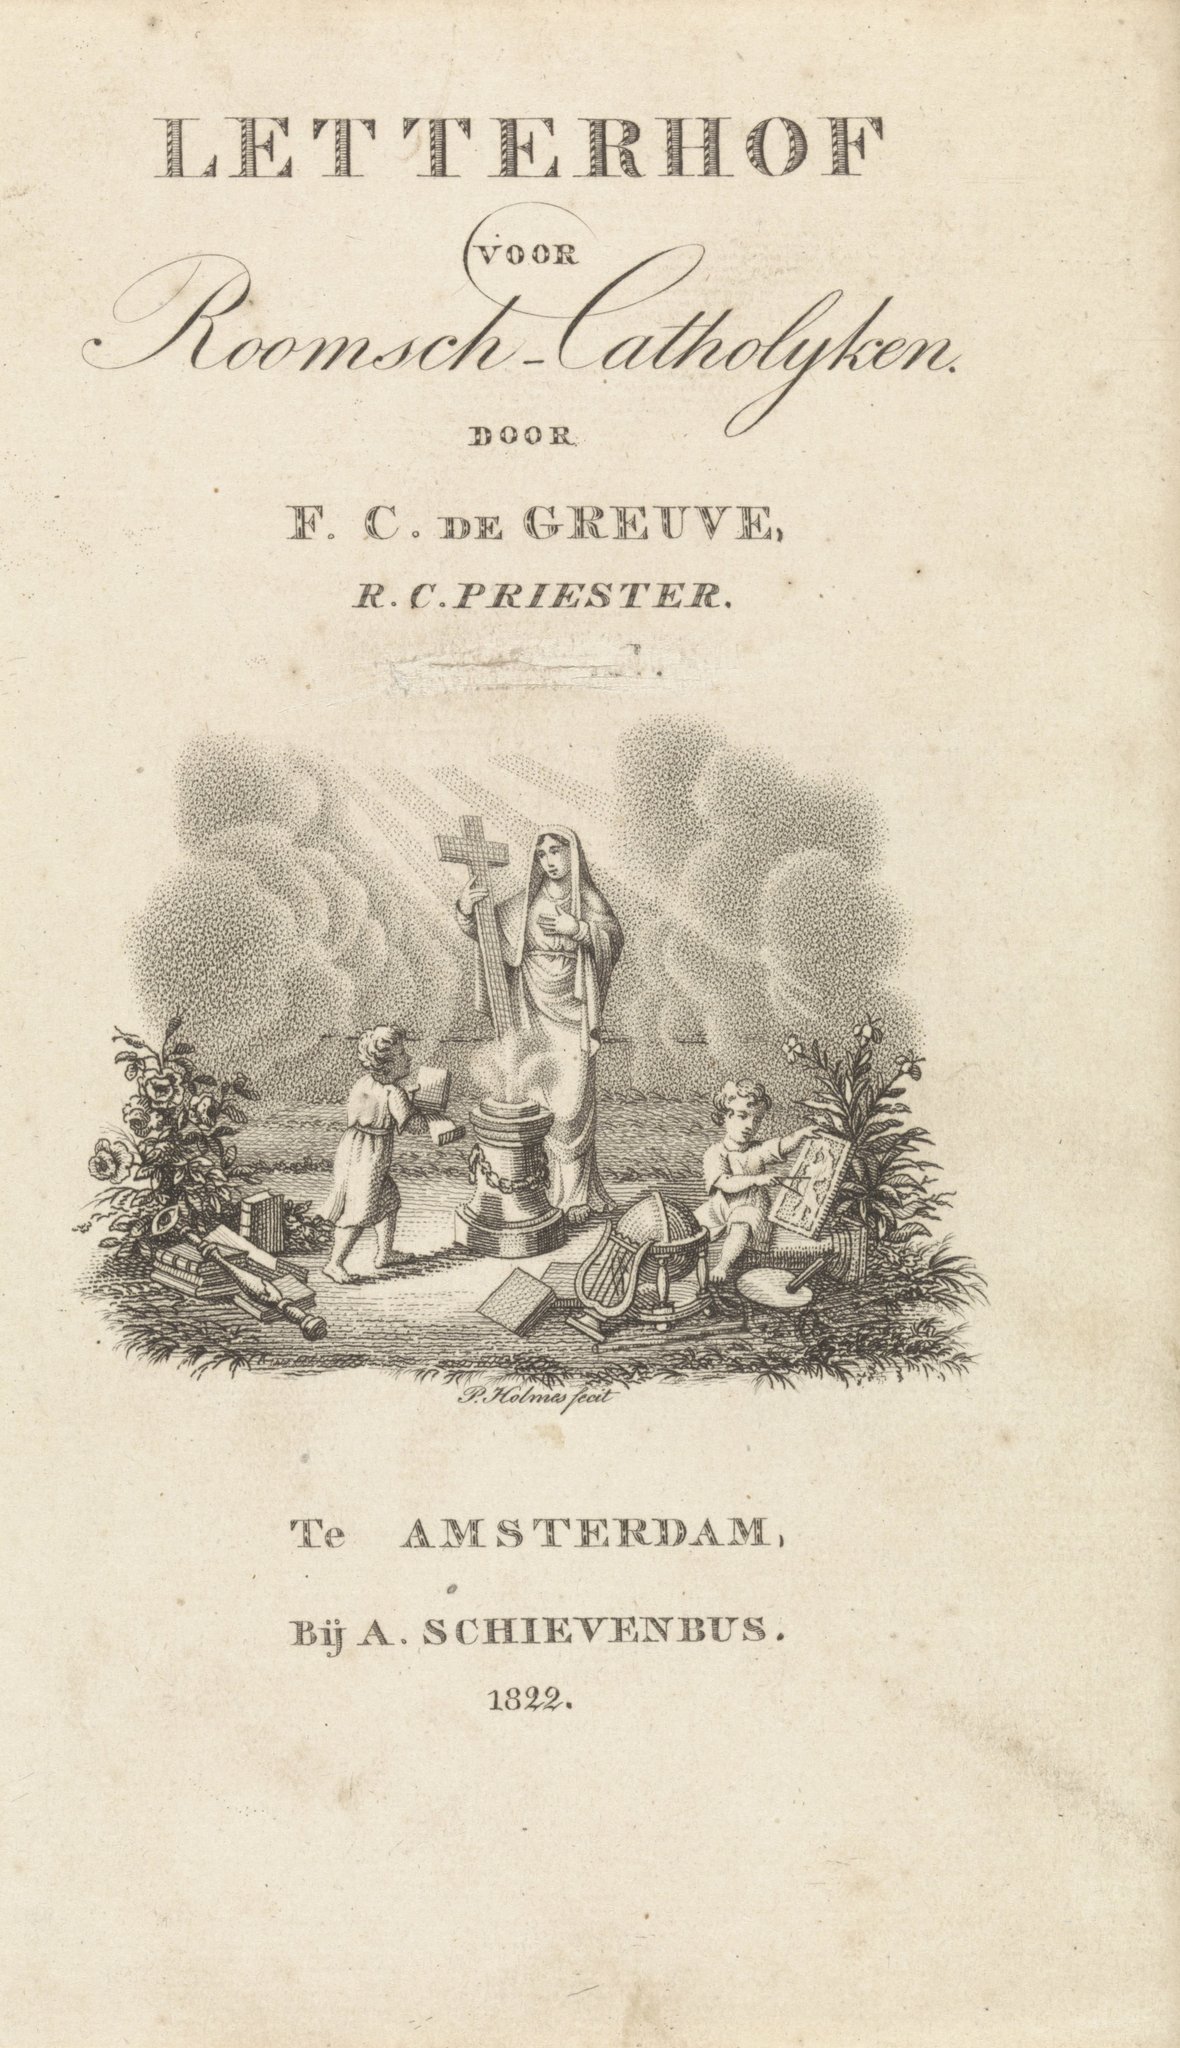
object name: print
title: Titelpagina voor: F. C. de Greuve, Letterhof voor Roomsch-Katholijken, 1822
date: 1822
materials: paper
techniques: etching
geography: amsterdam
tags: mary (without the christ-child)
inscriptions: collector's mark: Lugt 2228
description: Maria met een kruis bij een offerzuil. Op de achtergrond wolken en lichtstralen. Rechts op de voorgrond een jongen met een passer bij een kaart, een wereldbol, een schilderspalet en een lier. Links een jongen met boeken.